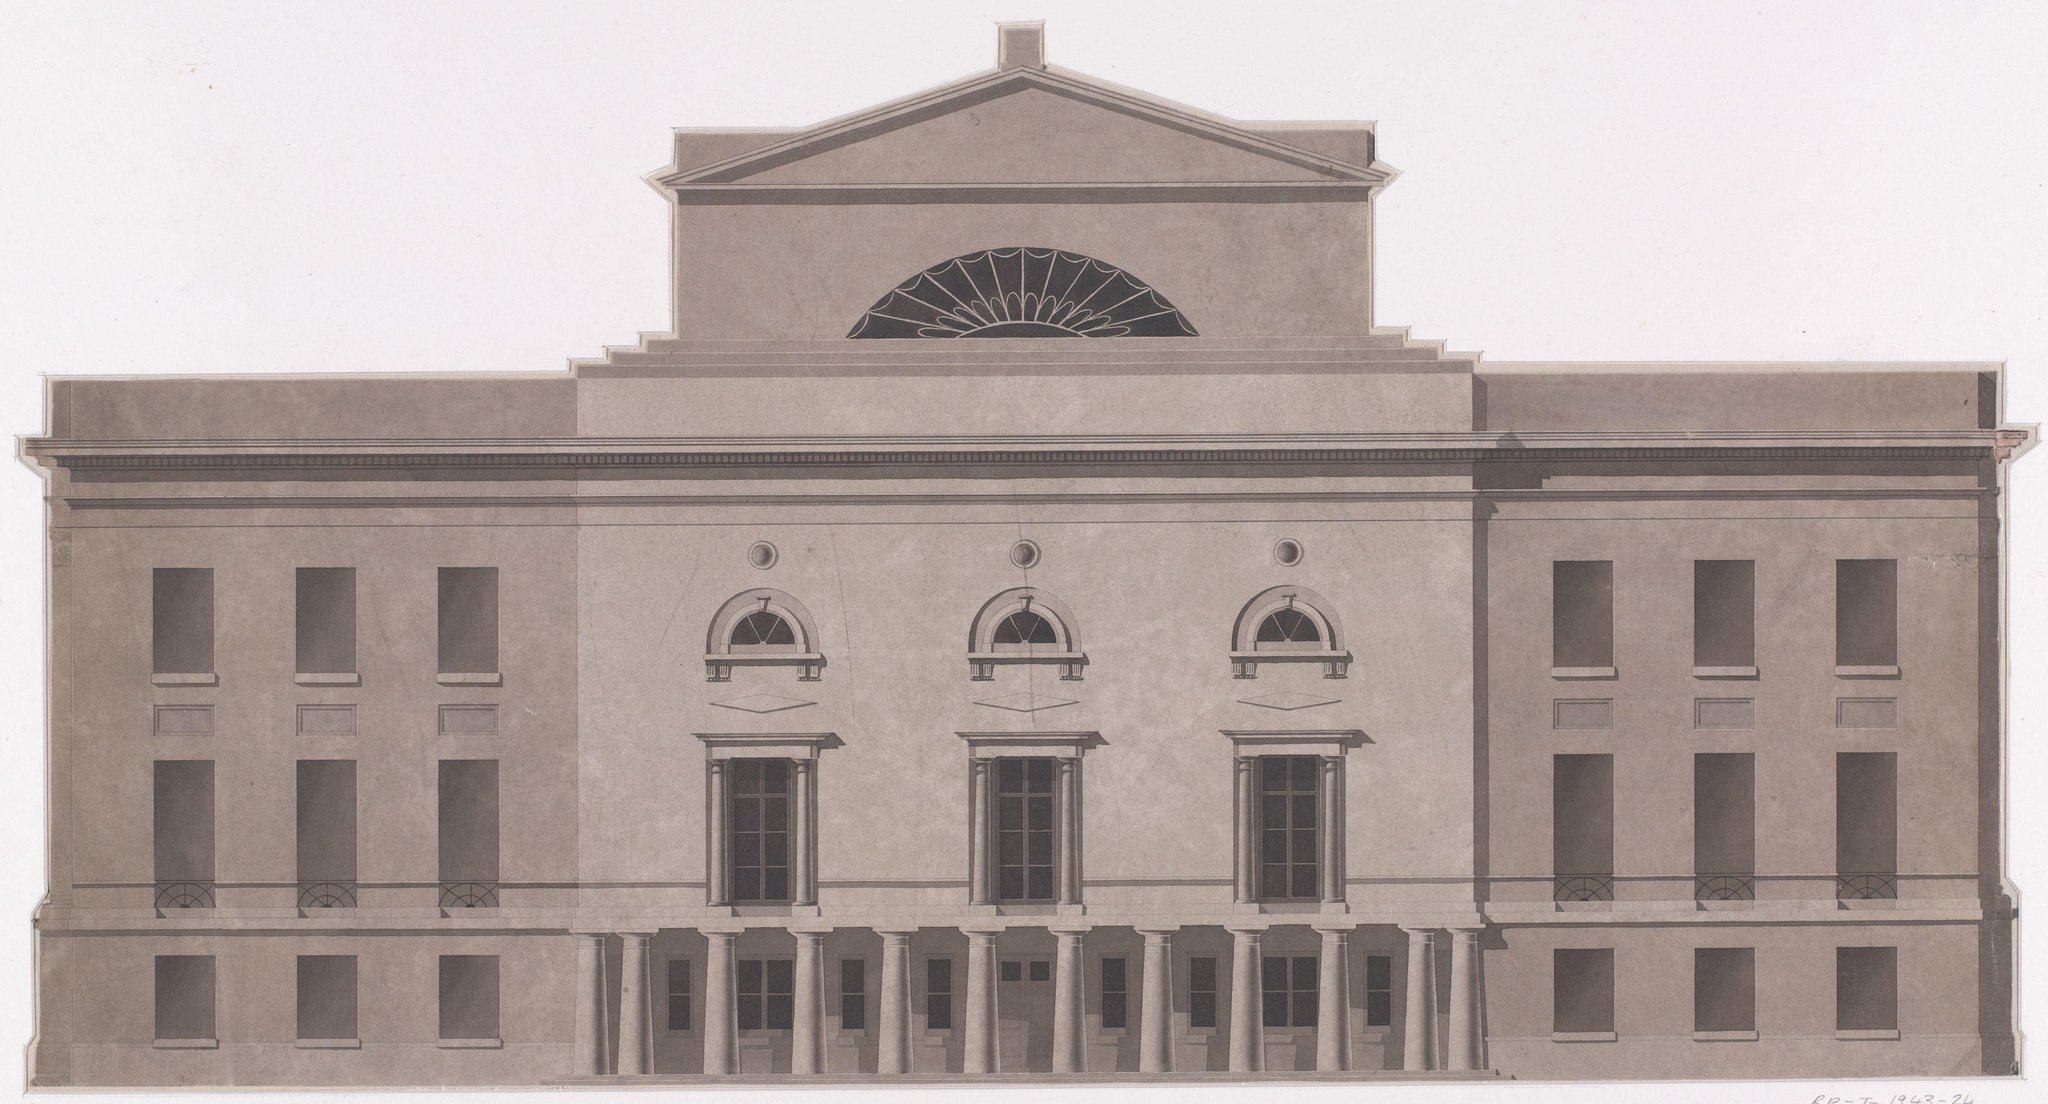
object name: drawing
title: Ontwerp voor een classicistisch gebouw (schouwburg?)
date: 1800-1900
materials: ink, paper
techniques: brush, pen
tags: exterior ~ architectural design or model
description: Gevelontwerp voor een schouwburg in classicistische stijl. De gehele breedte van het met een verhoogd fronton bekroonde middendeel wordt op straathoogte ingenomen door een Dorische colonnade, op welker zuilen de colonnetten ter weerszijden van de ramen op de eerste verdieping steunen. Daarboven halfronde vensters.